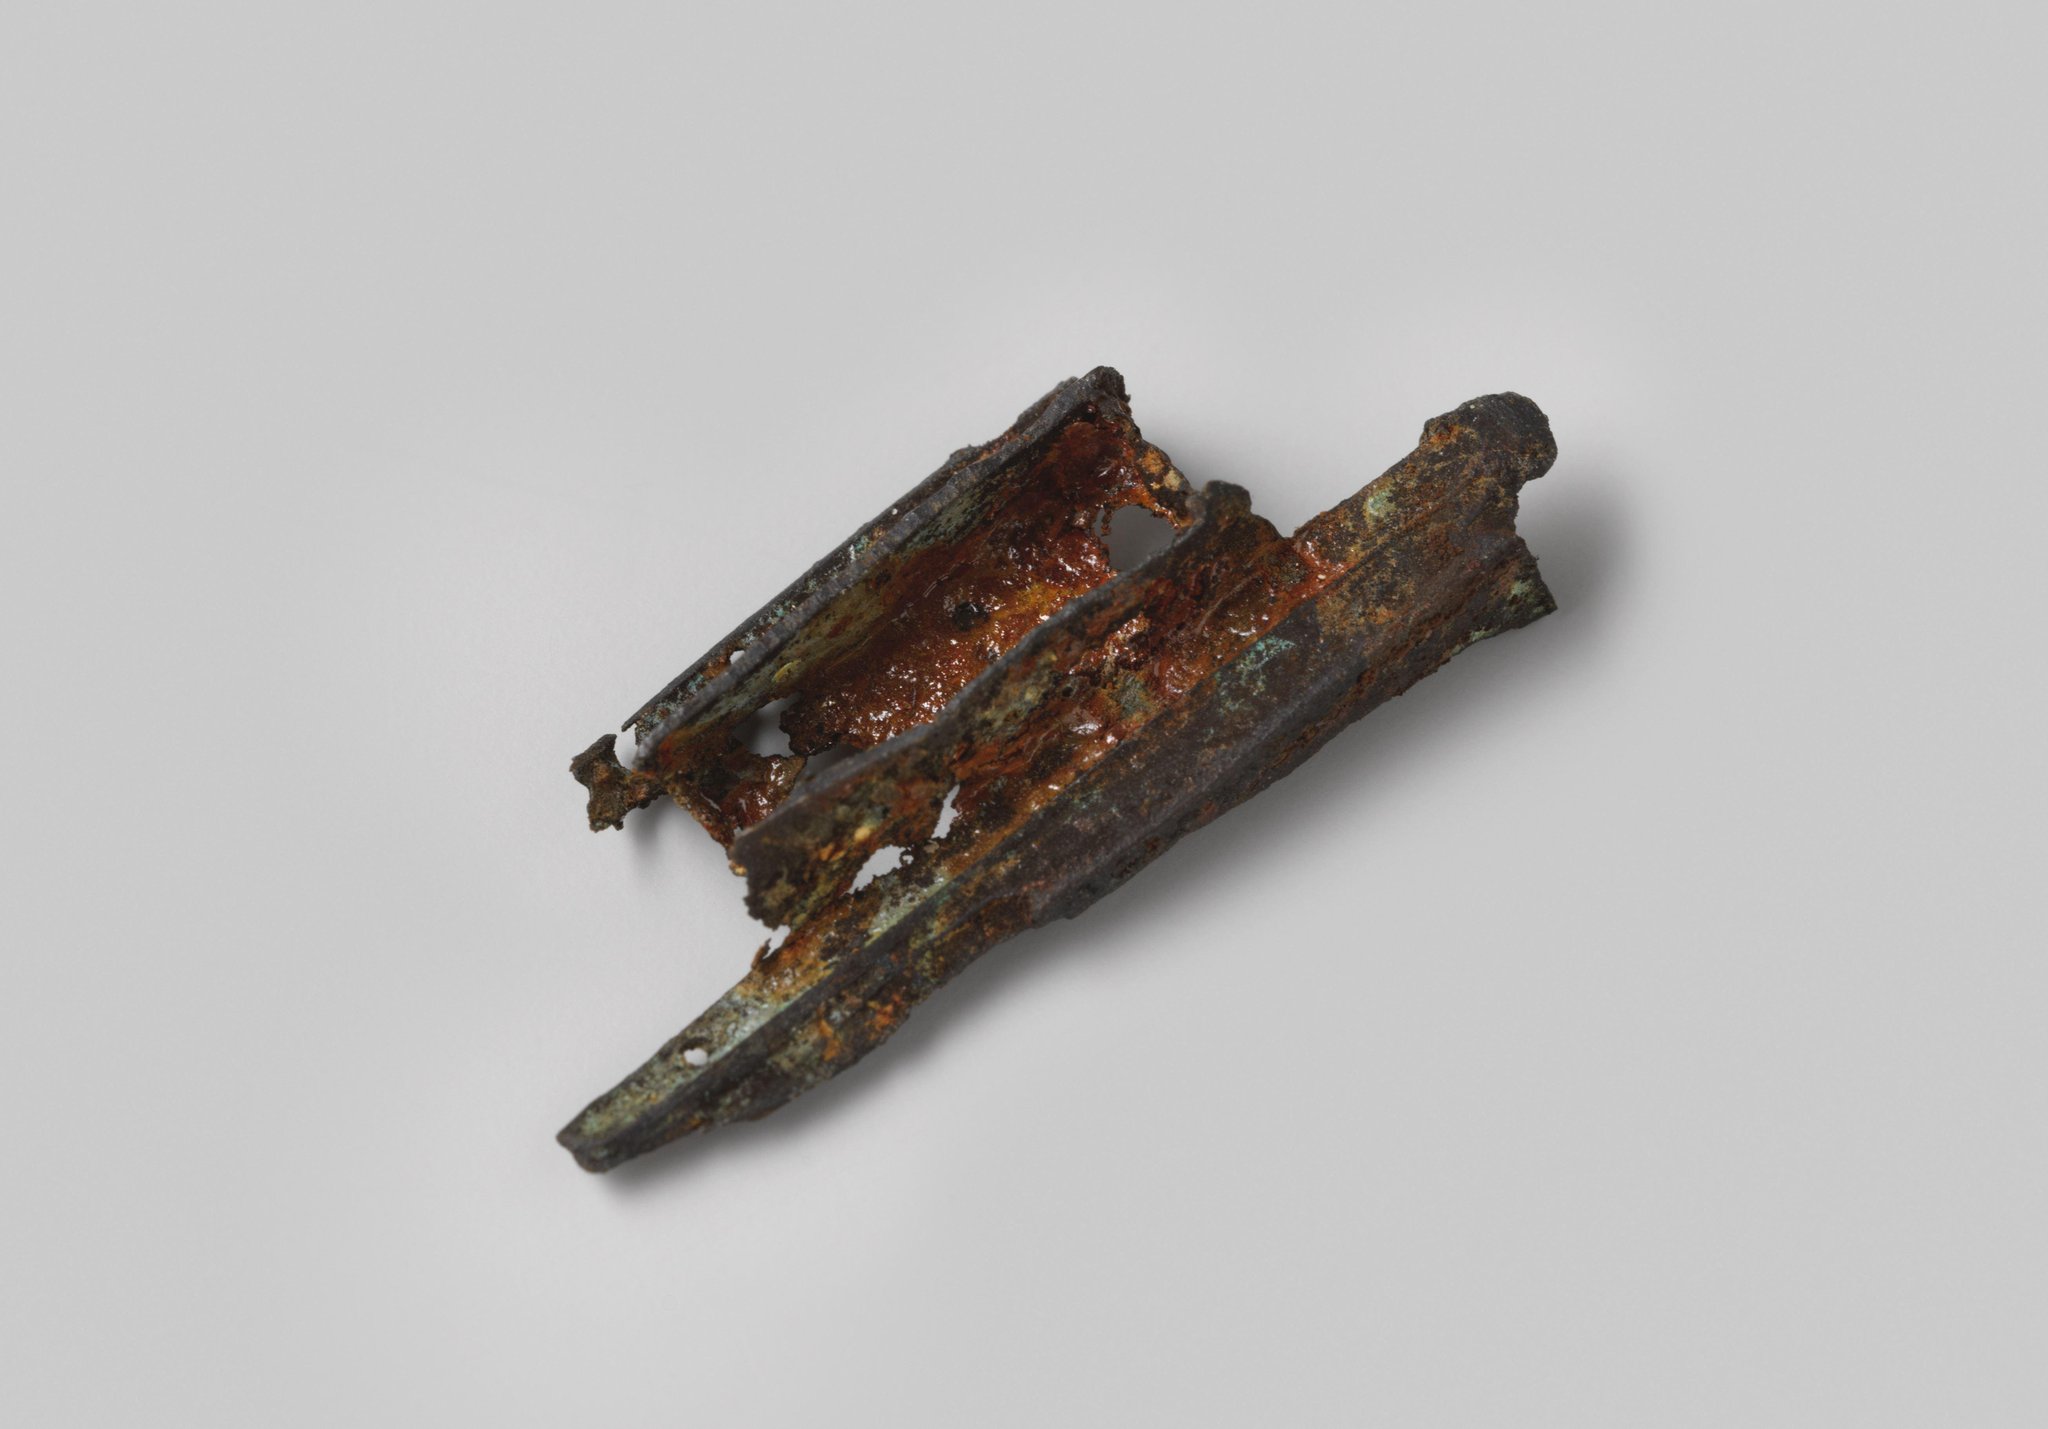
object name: fragment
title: Fragment van koper uit het wrak van de Oost-Indiëvaarder Hollandia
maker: Anonymous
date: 1700-1743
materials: copper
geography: netherlands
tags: verenigde oostindische compagnie, hollandia (schip), annet